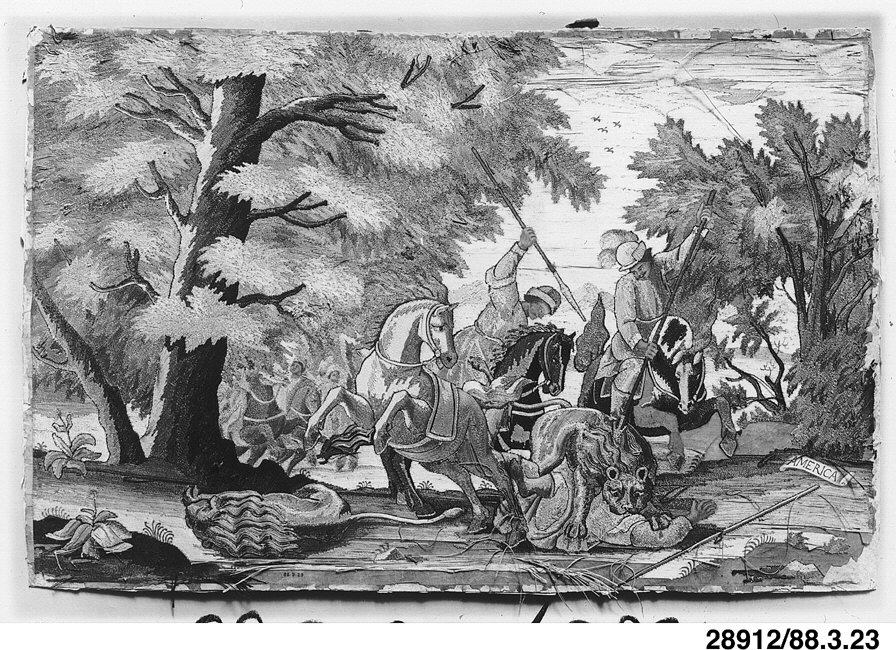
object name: embroidered picture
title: Lion Hunt ("America")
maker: leonardus quesi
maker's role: maker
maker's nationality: french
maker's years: 1650-1750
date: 1667-1700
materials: cardboard, silk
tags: spears,men,hunting,horses,lions